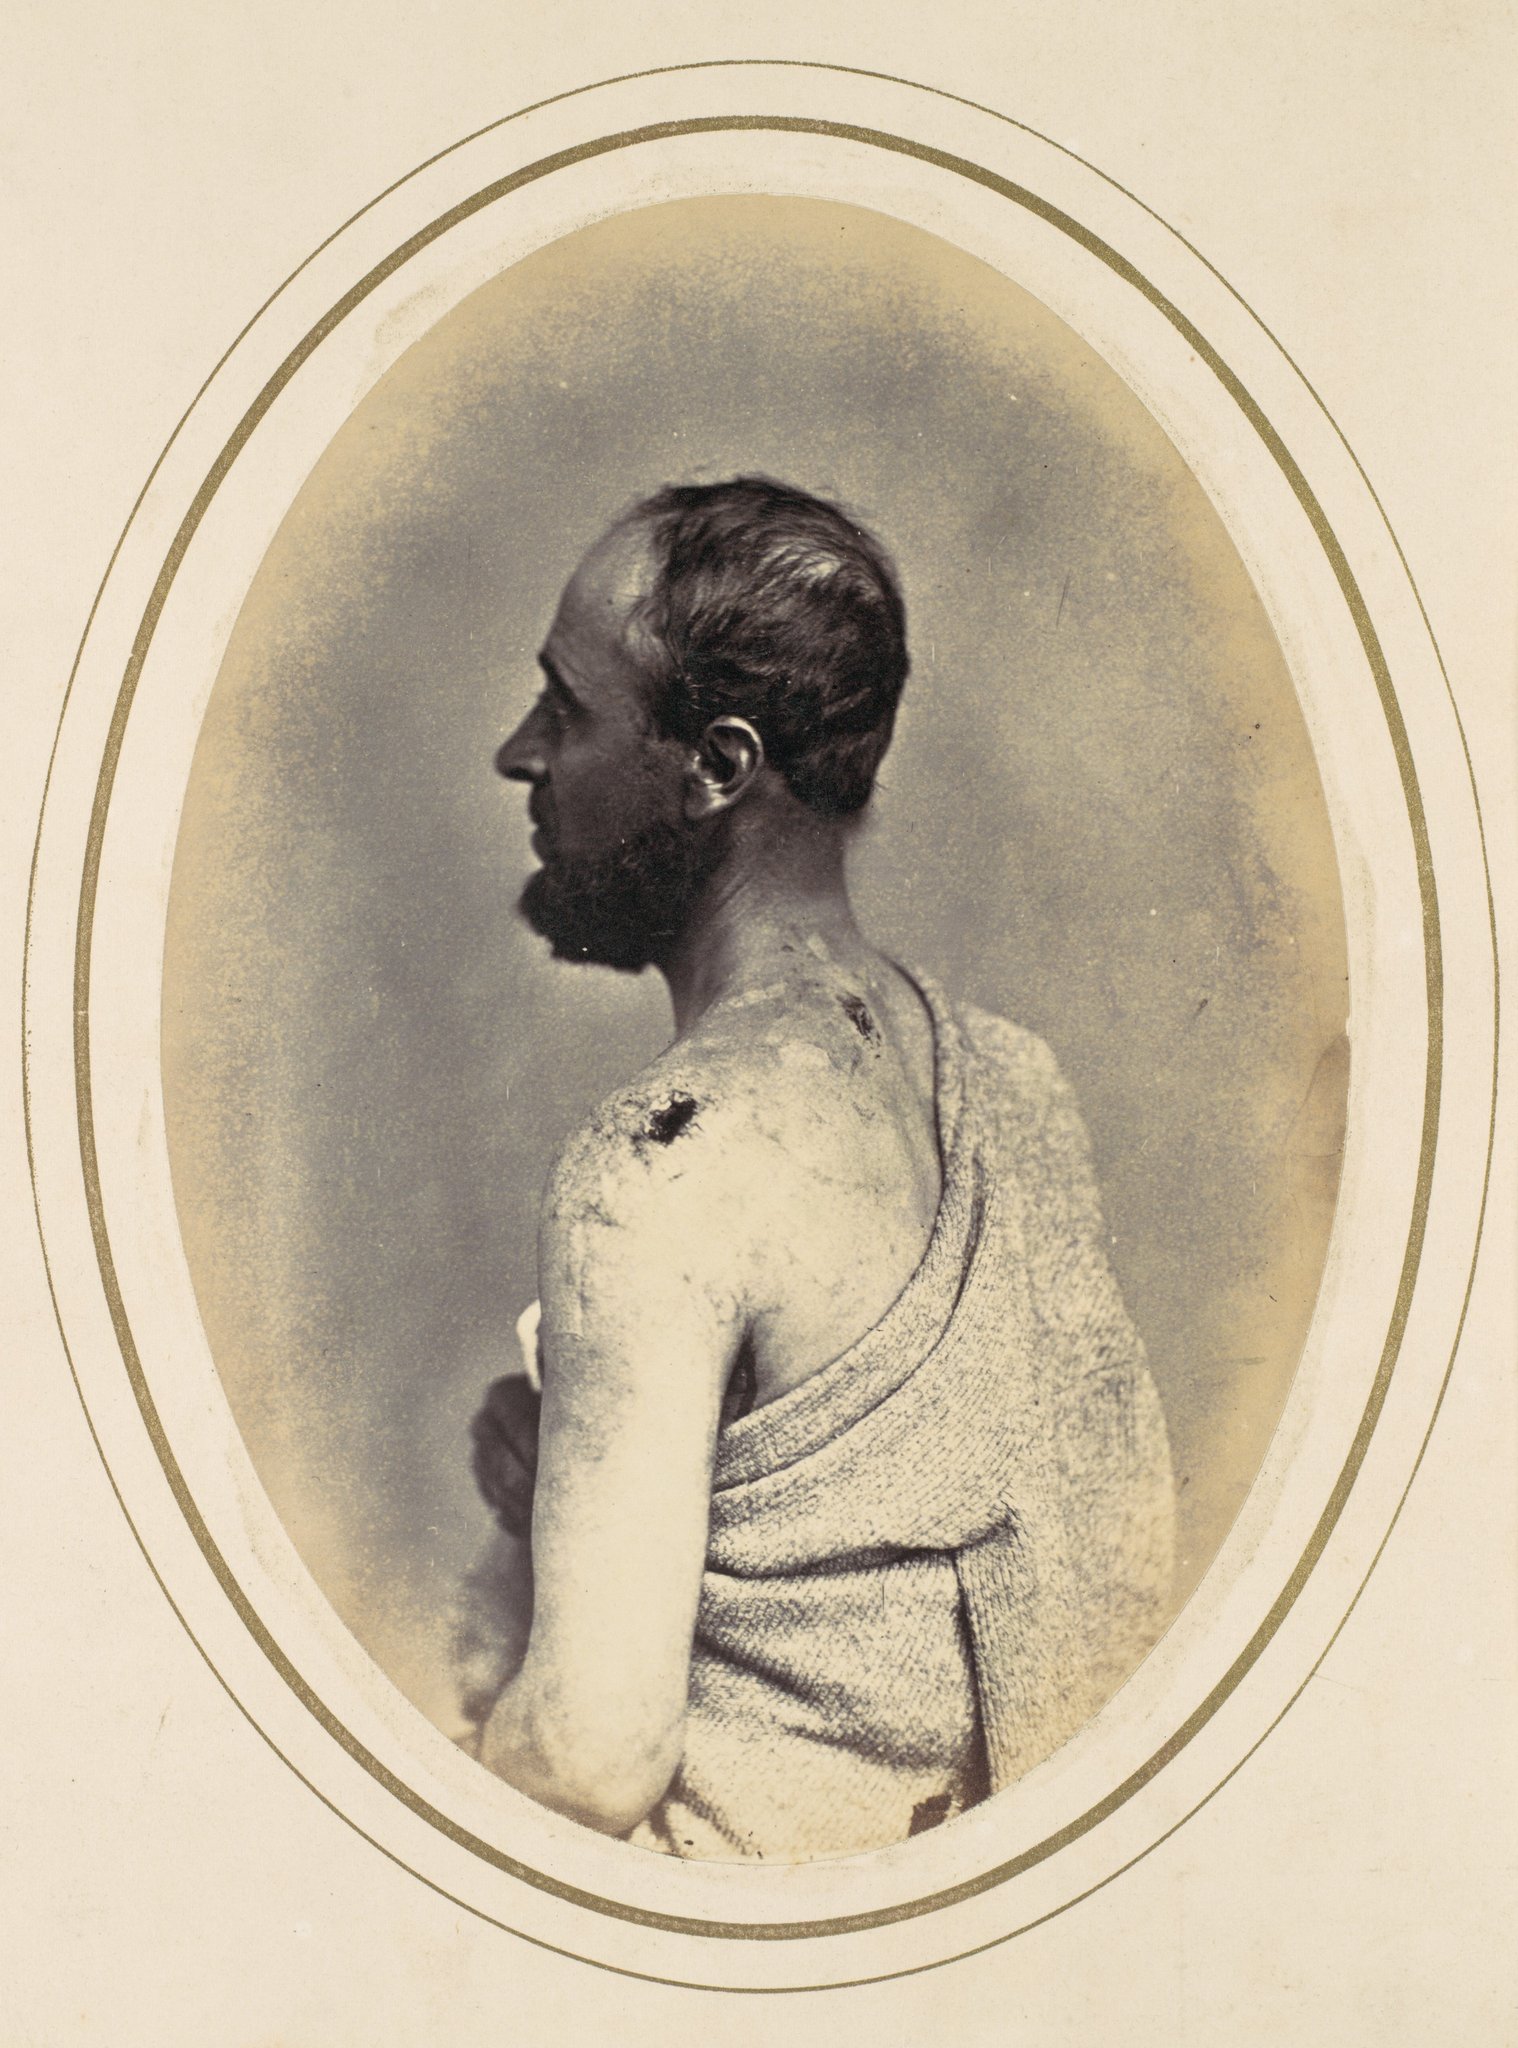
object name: photograph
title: Henry Yon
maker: reed brockway bontecou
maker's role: artist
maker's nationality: american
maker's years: 1824-1907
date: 1865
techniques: albumen silver print, glass negative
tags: soldiers,american civil war,men,portraits,profiles